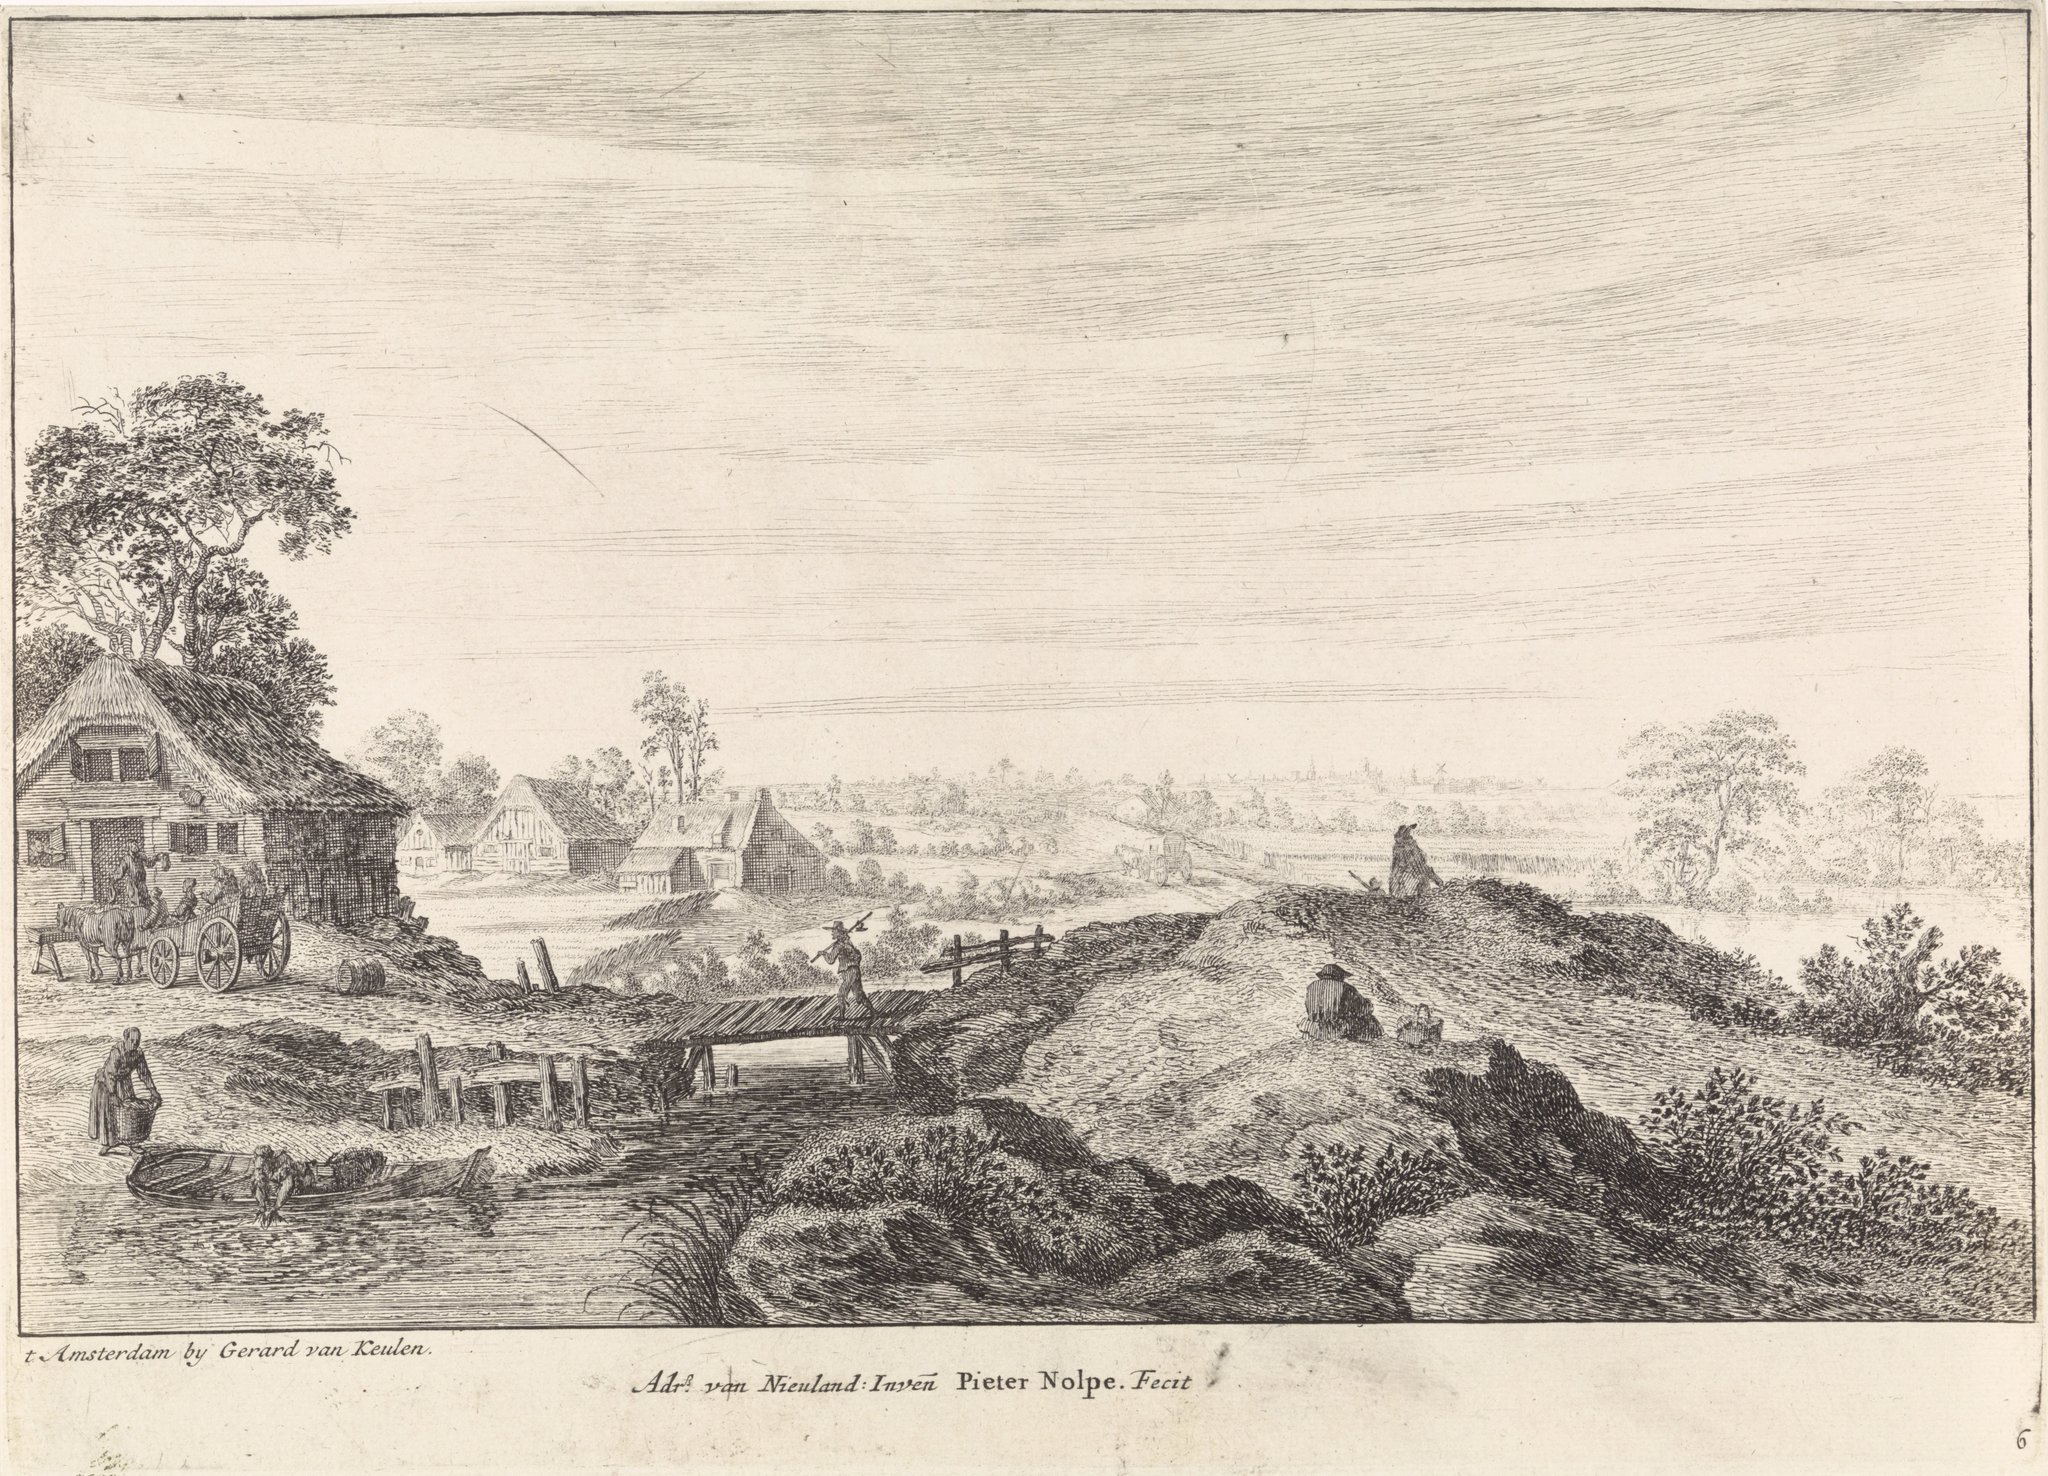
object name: print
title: Landschap met boerderijen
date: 1688-1727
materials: paper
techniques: engraving, etching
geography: amsterdam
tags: four-wheeled, animal-drawn vehicle, e.g.: cab, carriage, coach, landscape with bridge, viaduct or aqueduct, farm (building), angling (+ net)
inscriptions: collector's mark: Lugt 2228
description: In een landschap liggen enkele boerderijen. Bij het huis links staat een koets stil, waarvan de paarden drinken. Links trekt een man vanuit een boot een visnet uit het water. Rechts zit een man op de dijk. Prent uit een serie landschappen.